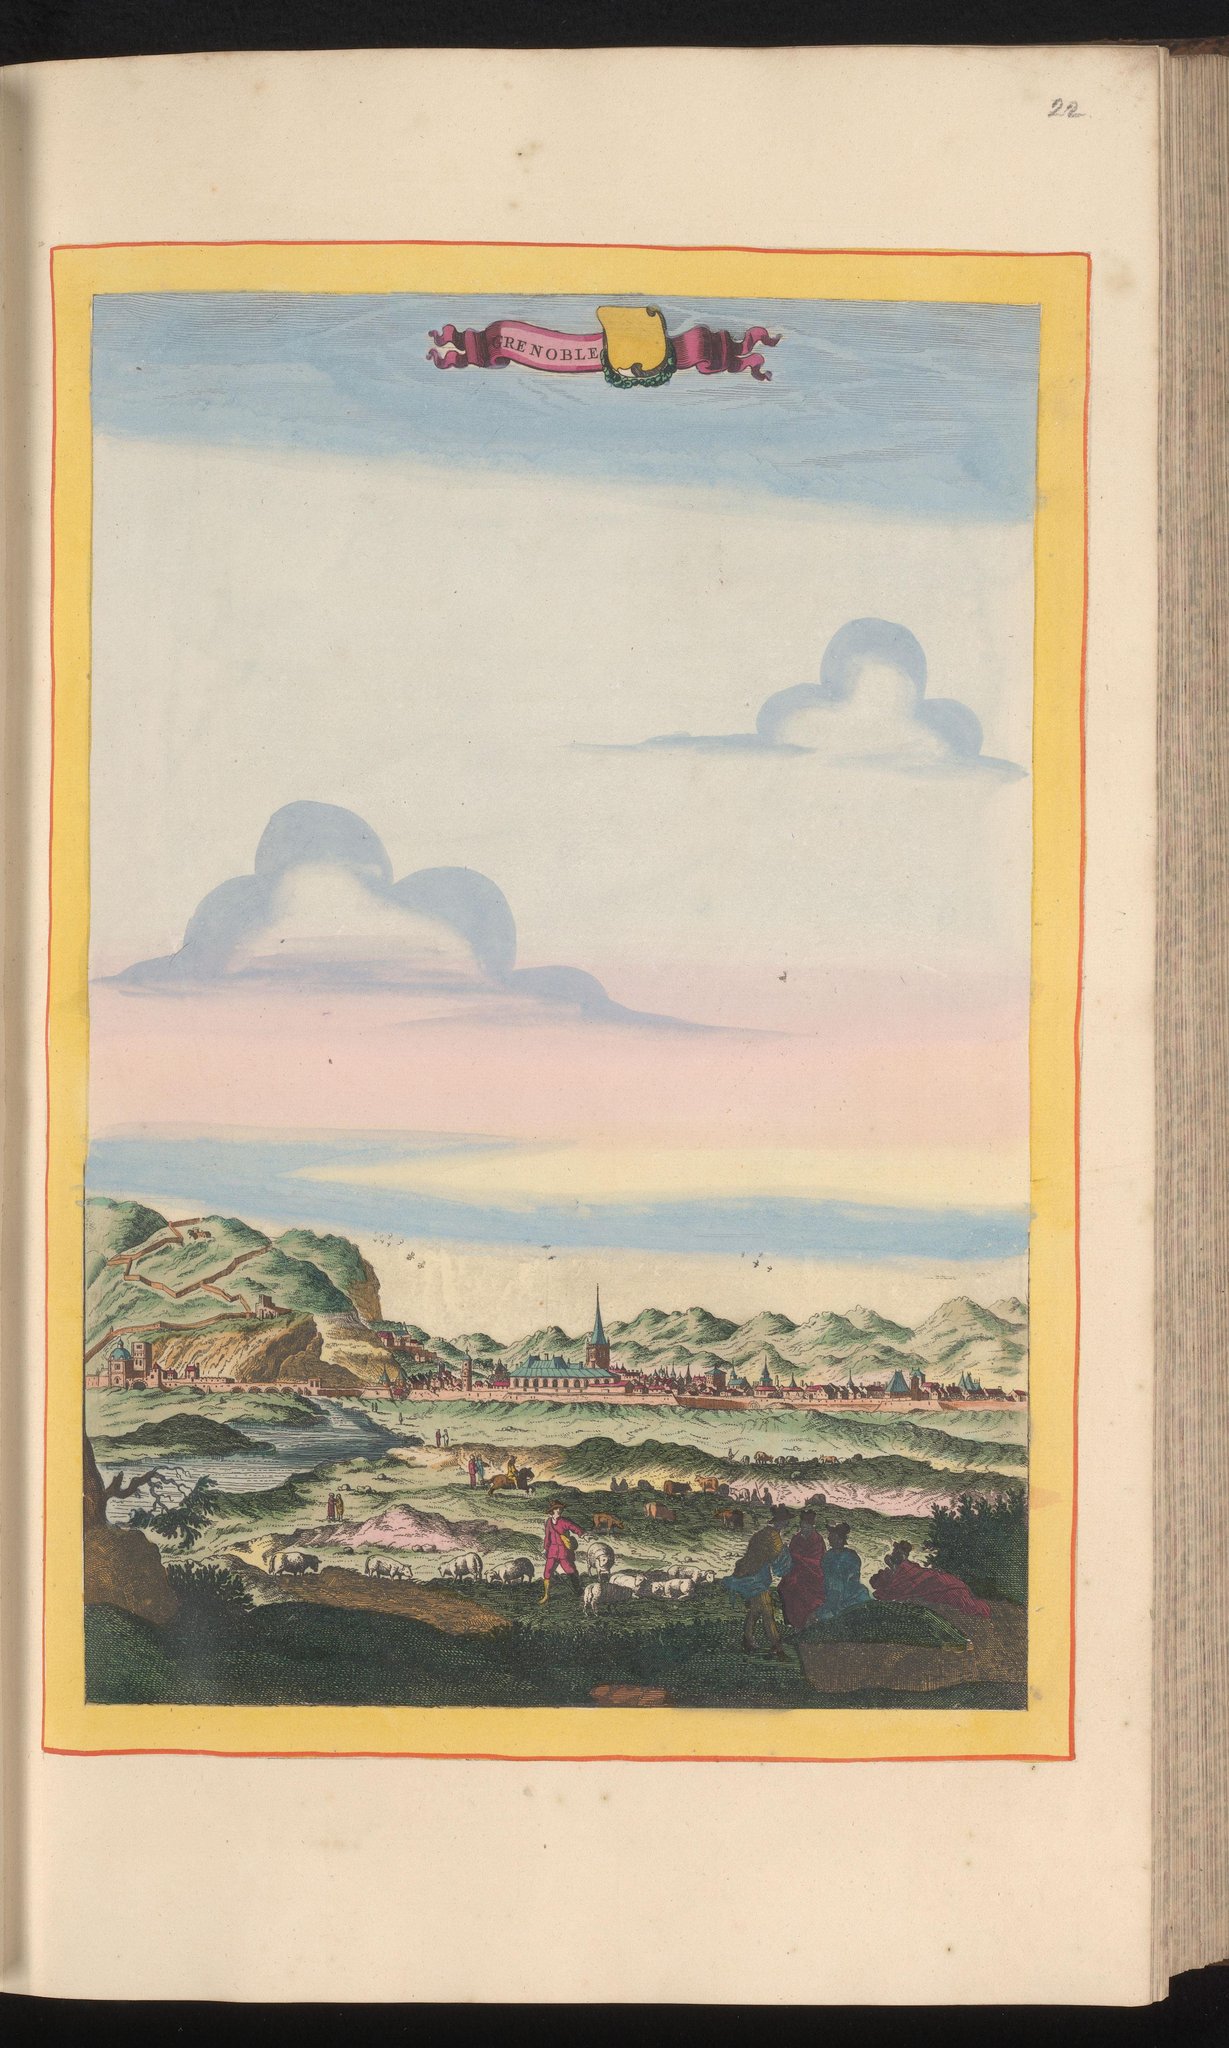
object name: print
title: Grenoble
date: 1600-1699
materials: paper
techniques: engraving, etching, hand coloring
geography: the hague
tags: city-view in general; 'veduta'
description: Deze prent maakt deel uit van een album.